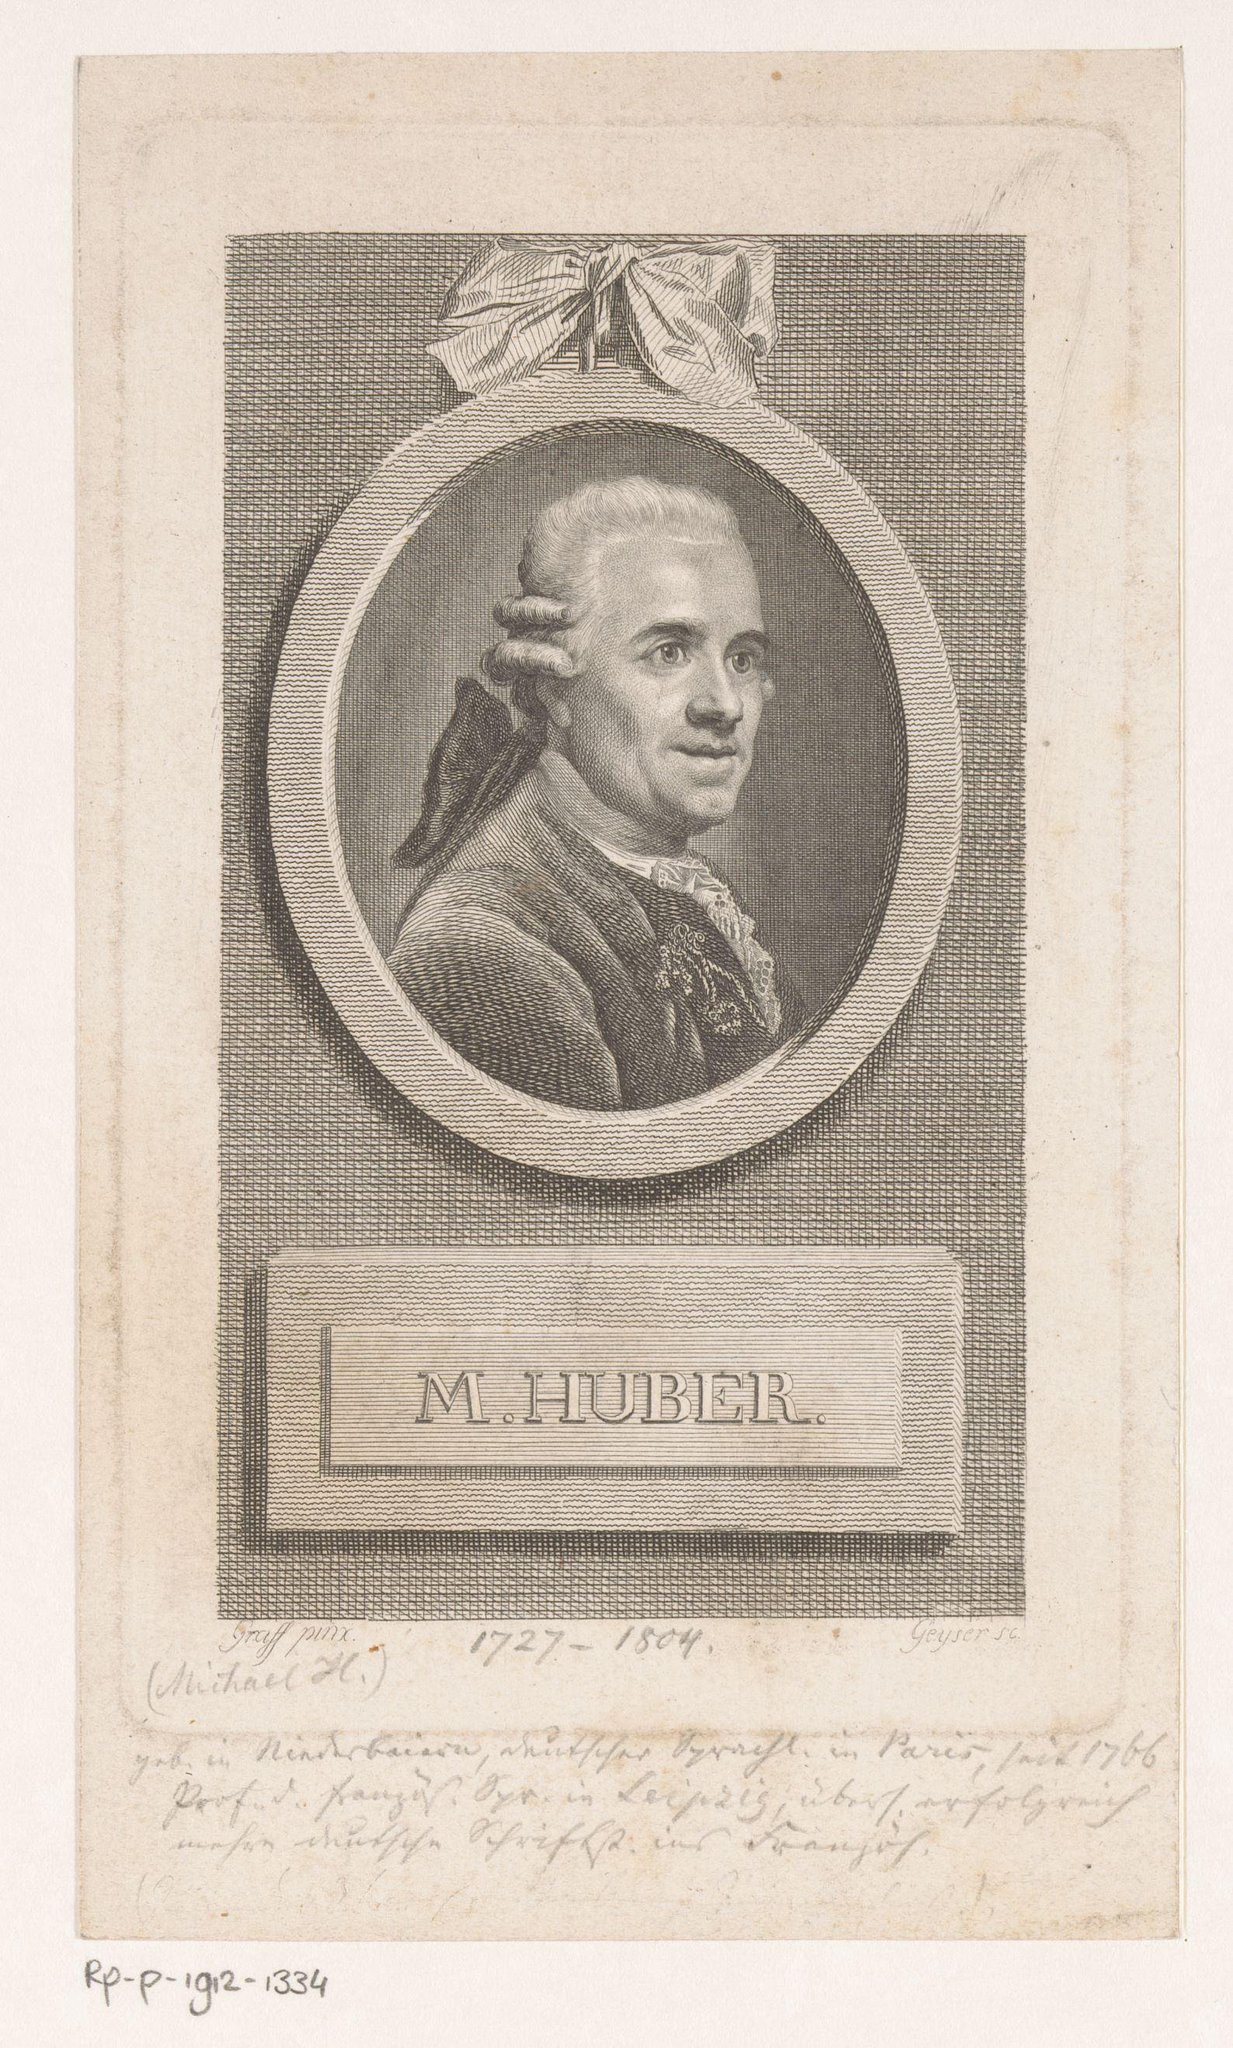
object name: print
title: Portret van Michael Huber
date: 1752-1803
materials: paper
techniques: engraving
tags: ornament ~ medallion, historical persons, portrait of a writer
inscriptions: collector's mark: Lugt 2228